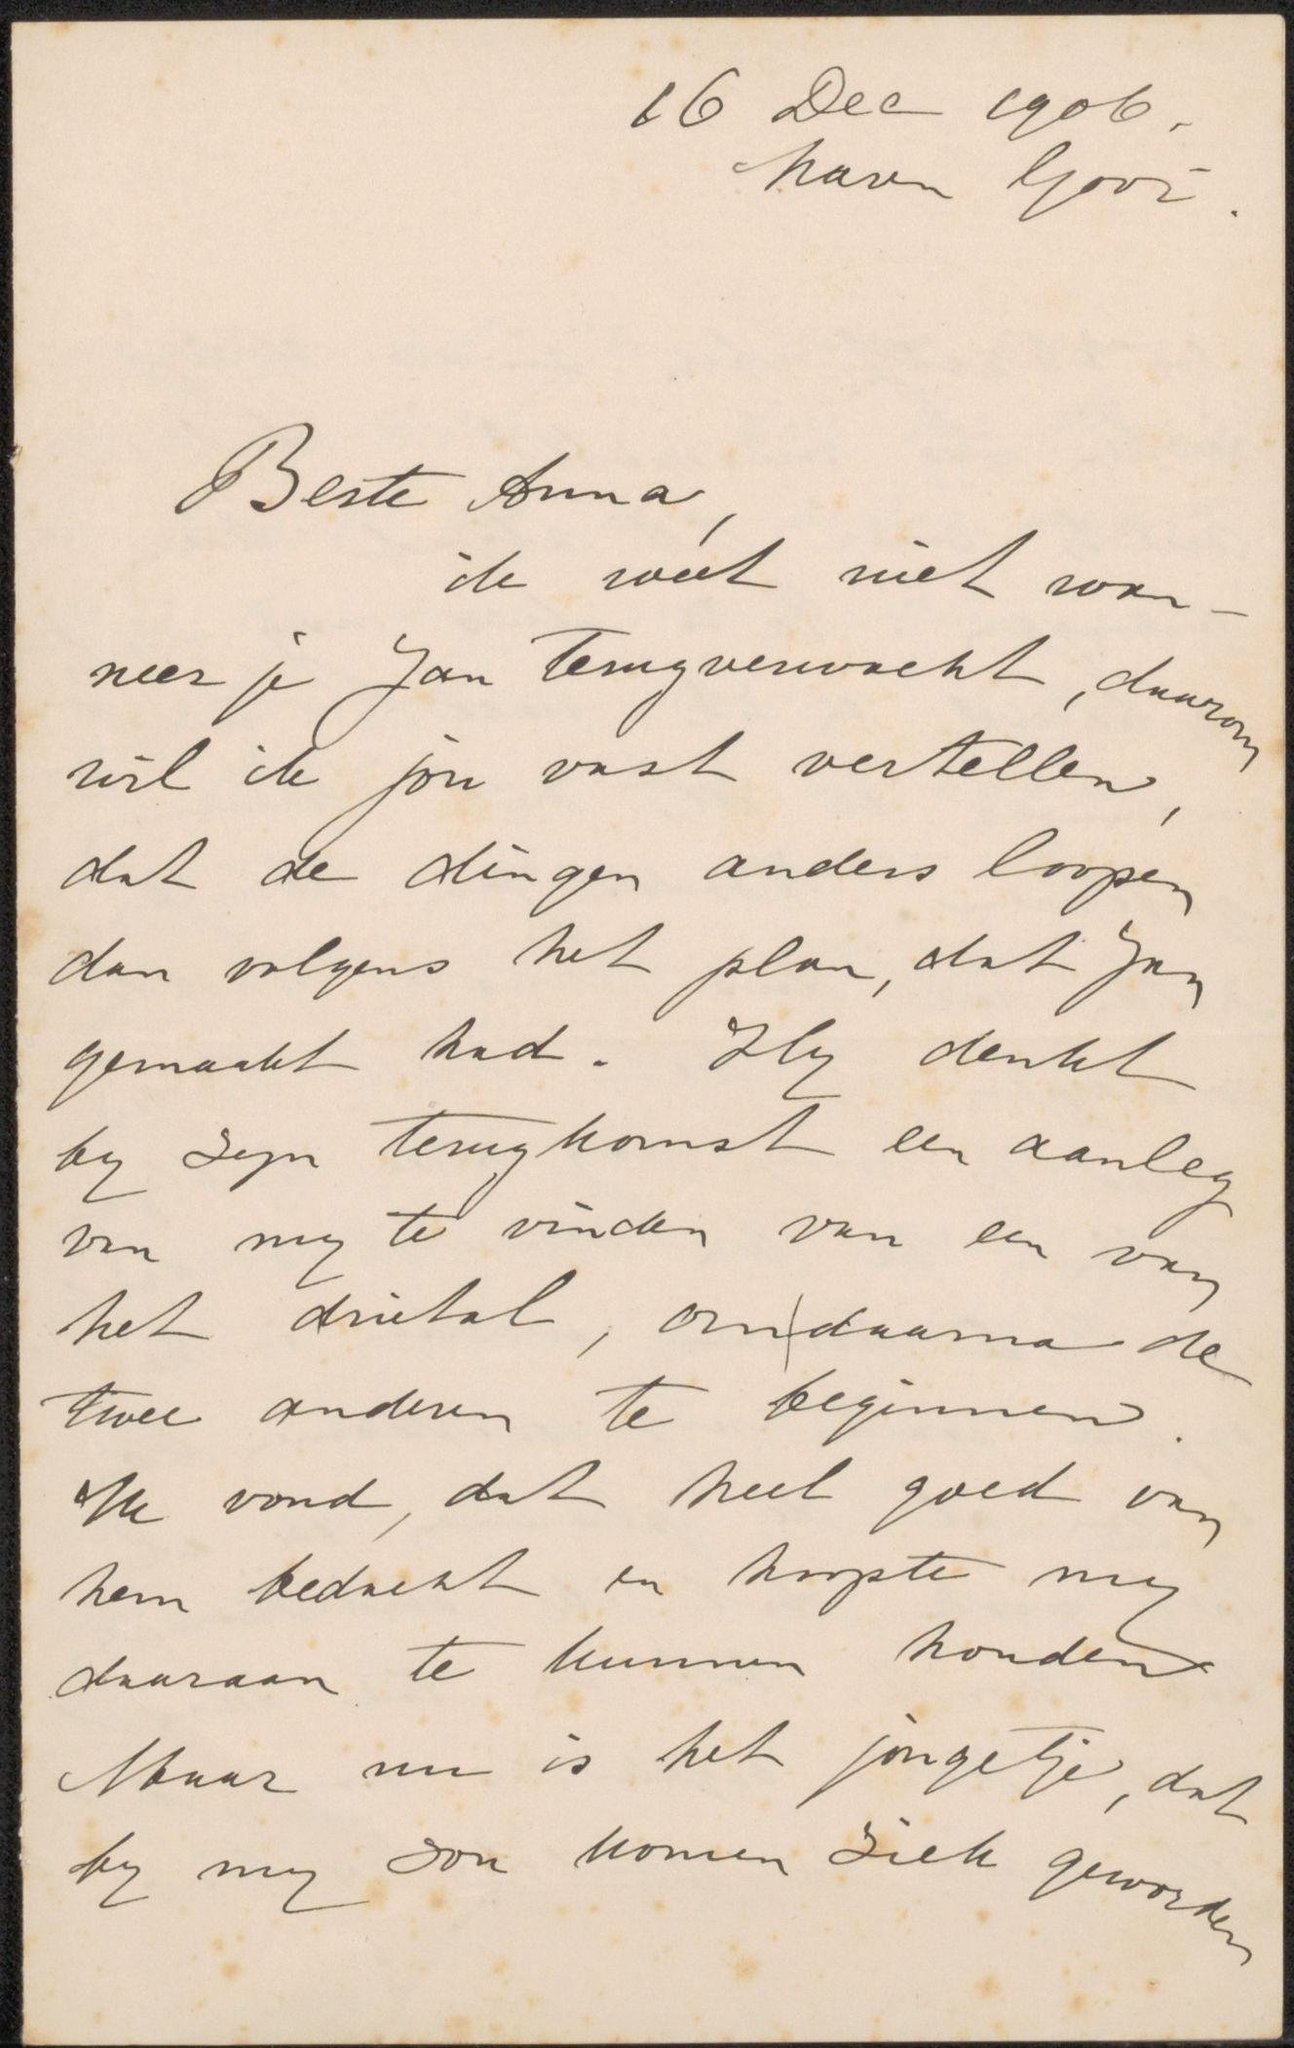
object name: letter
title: Brief aan Anna Dorothea Dirks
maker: wally moes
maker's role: draughtsman, print maker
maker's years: 1856-1918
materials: ink, paper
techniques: pen, writing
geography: het gooi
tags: dordrecht, painter, designer, jan veth, artist, anna dorothea dirks, passions, emotions, affections, diseases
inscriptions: collector's mark: ‘RPK’